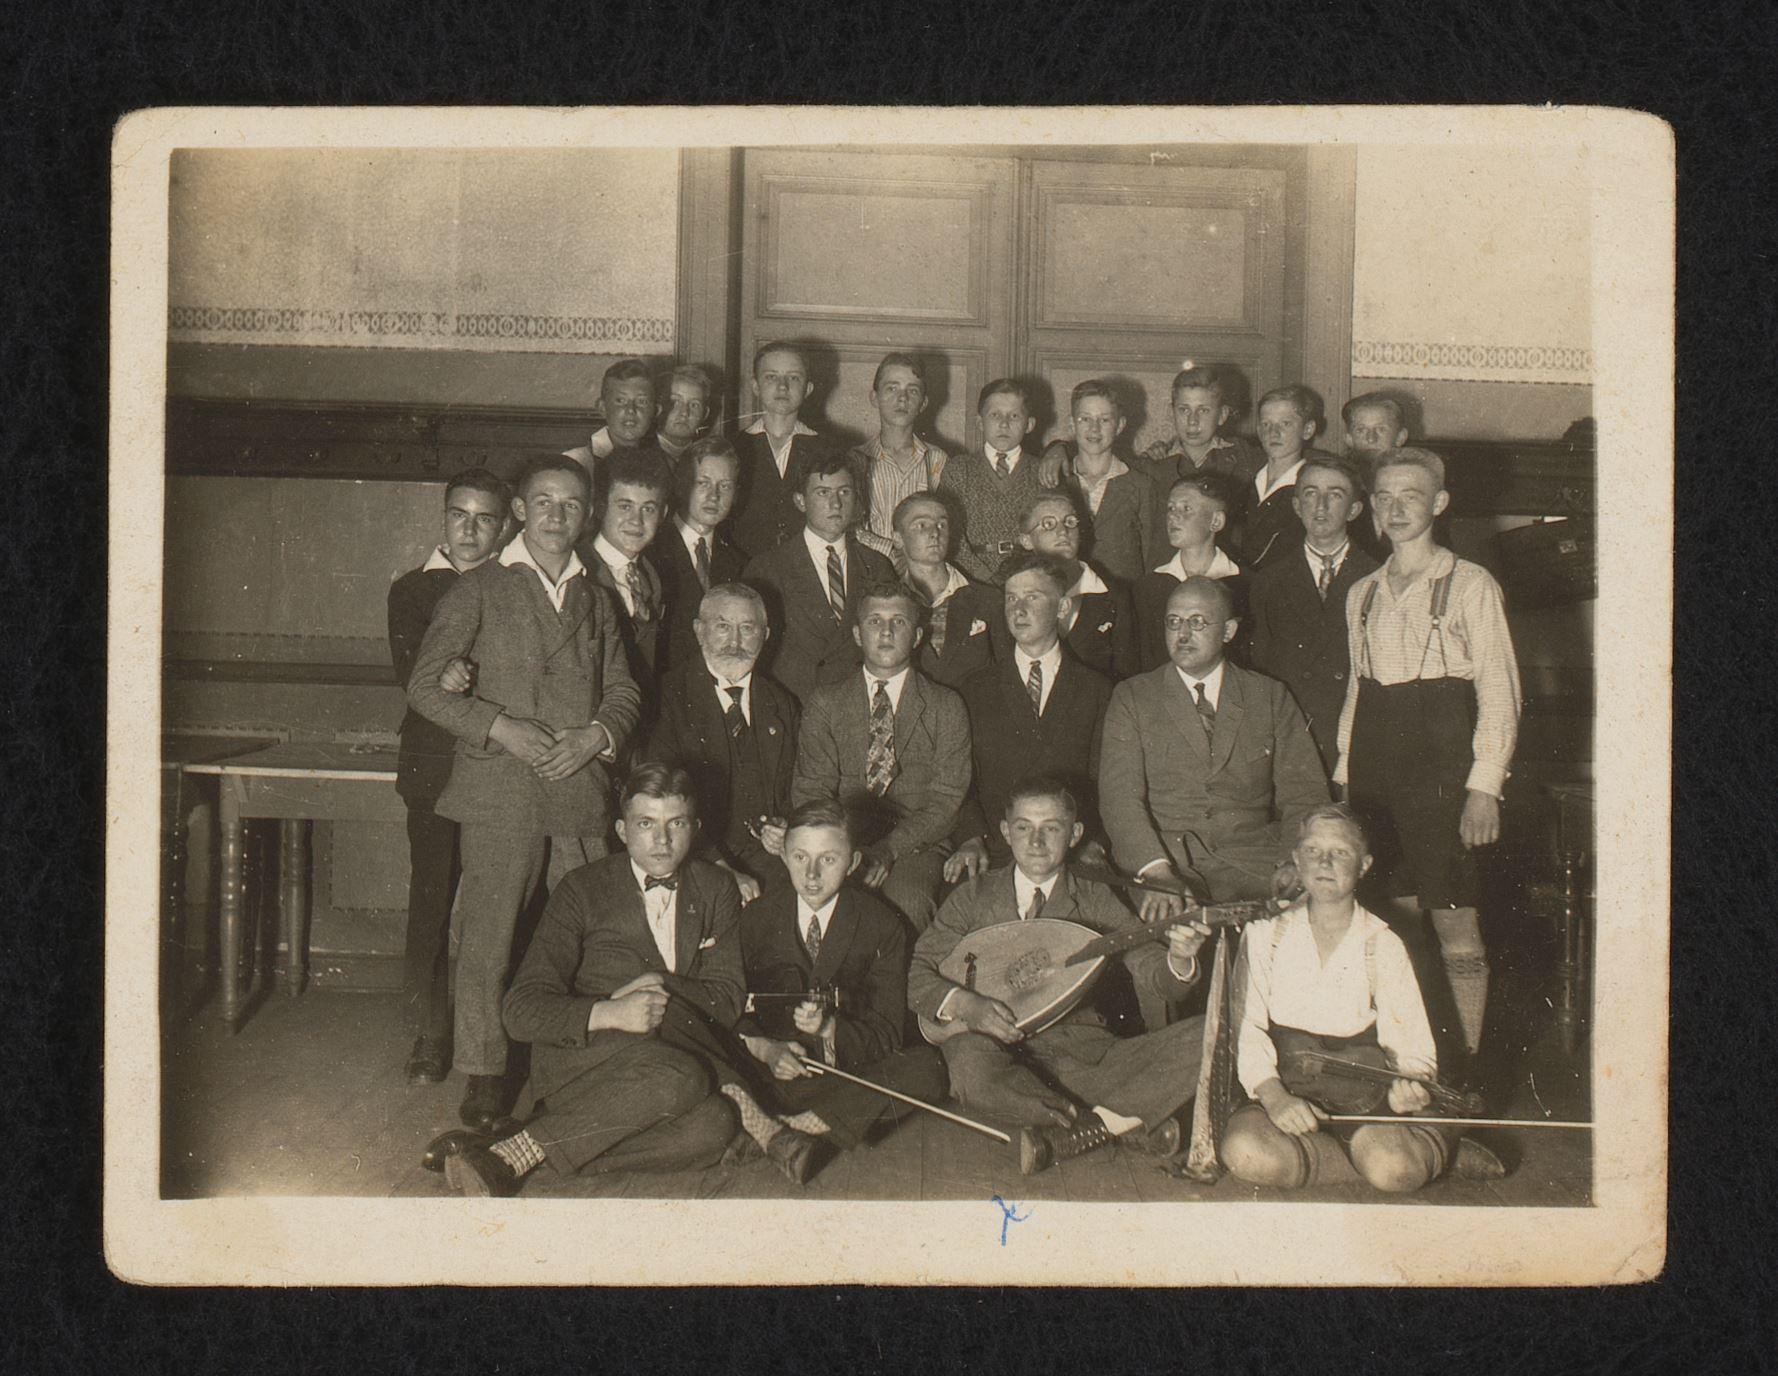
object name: photograph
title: Muziekgroep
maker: Anonymous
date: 1925-1935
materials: paper, photographic support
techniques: gelatin silver print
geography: germany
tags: werner neufang, musician training pupils, music-lesson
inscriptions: inscription: ‘Blitzlichtaufnahme der Horde "Klinkenputzer" ...’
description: Groepsportret van een muziekgroep waartoe Werner in zijn jeugd behoorde. Onderdeel van de groep losse foto's behorend bij het fotoalbum over de Duitse Werner Neufang van de Kriegsmarine en de Nederlandse Thea Driesen.